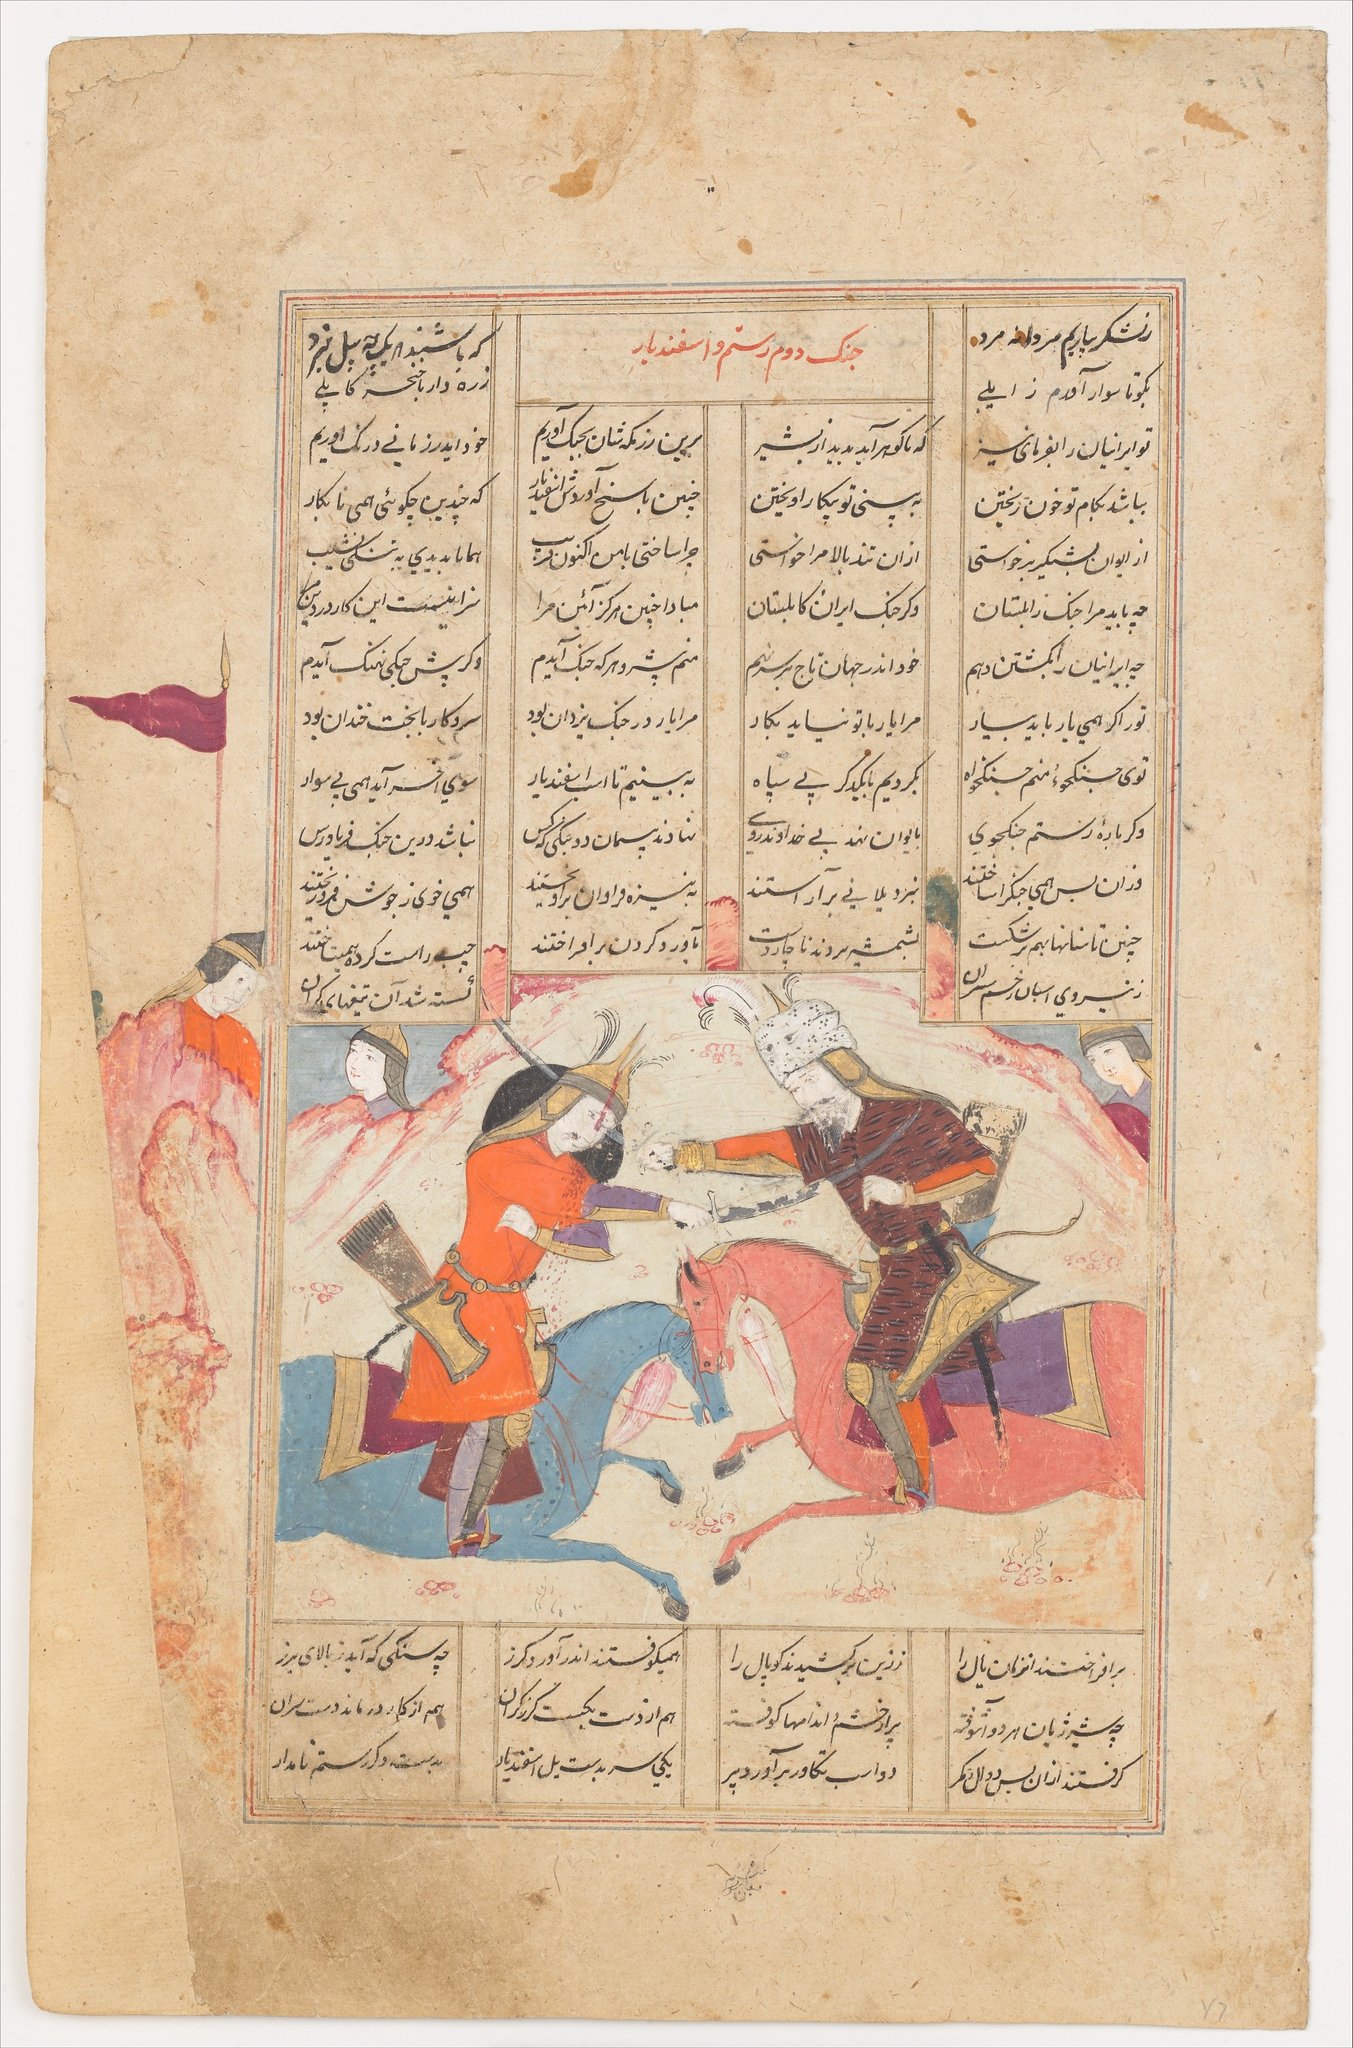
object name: folio from an illustrated manuscript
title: "Rustam Slays Esfandiyar", Folio from a Shahnama (Book of Kings)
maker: abu'l qasim firdausi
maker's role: author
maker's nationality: iranian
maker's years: 935-1020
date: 1666-1667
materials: gold, ink, paper, silver, watercolor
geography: iran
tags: battles,men,horses